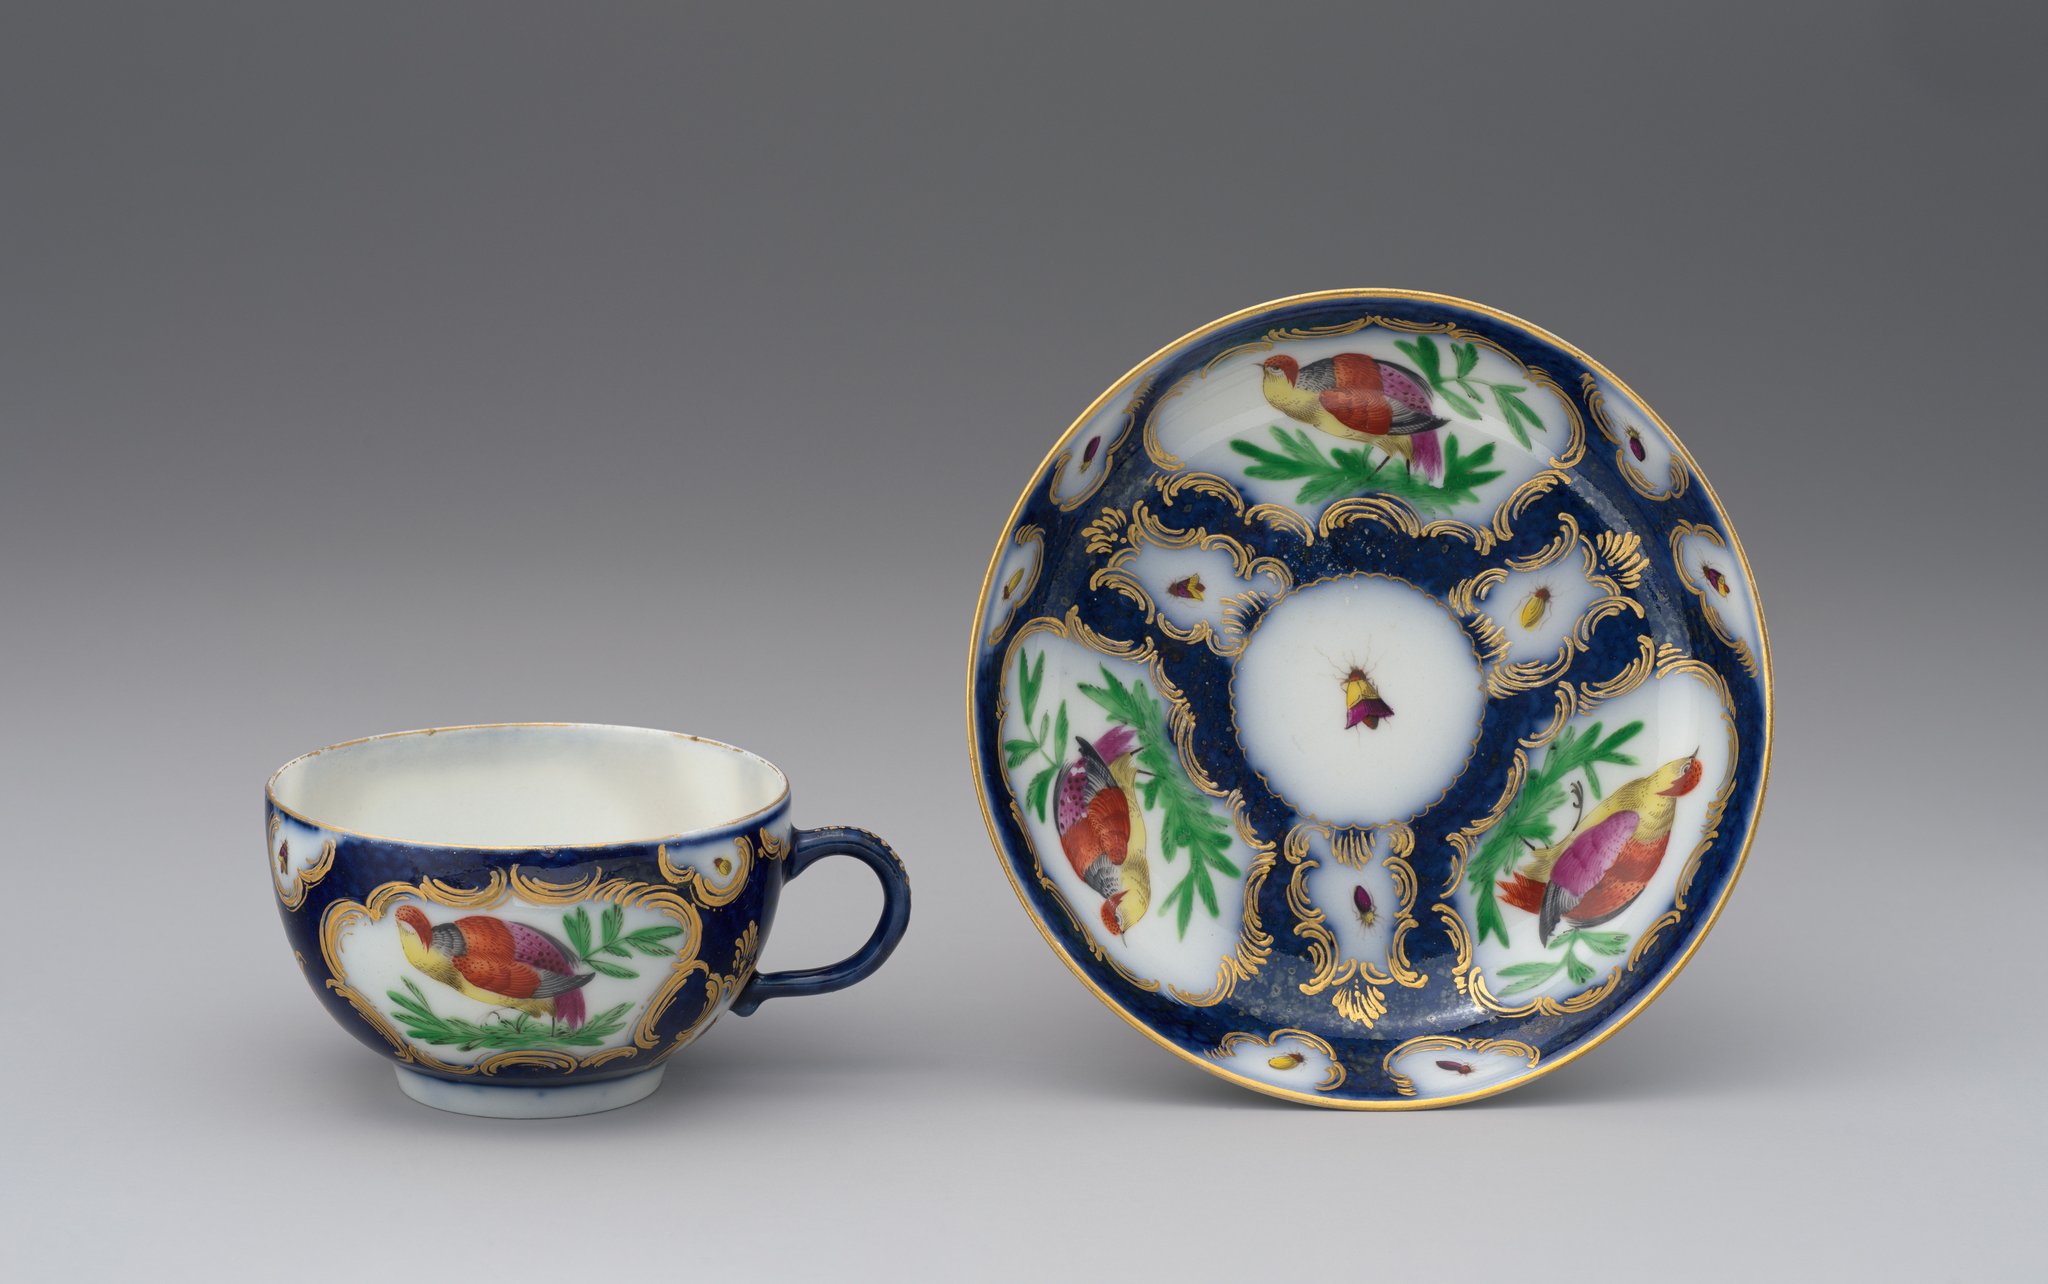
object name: cup and saucer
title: Cup and saucer in the style of Worcester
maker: edmé samson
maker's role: maker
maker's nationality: french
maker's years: 1810-1891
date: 1801-1900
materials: hard paste porcelain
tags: birds,insects